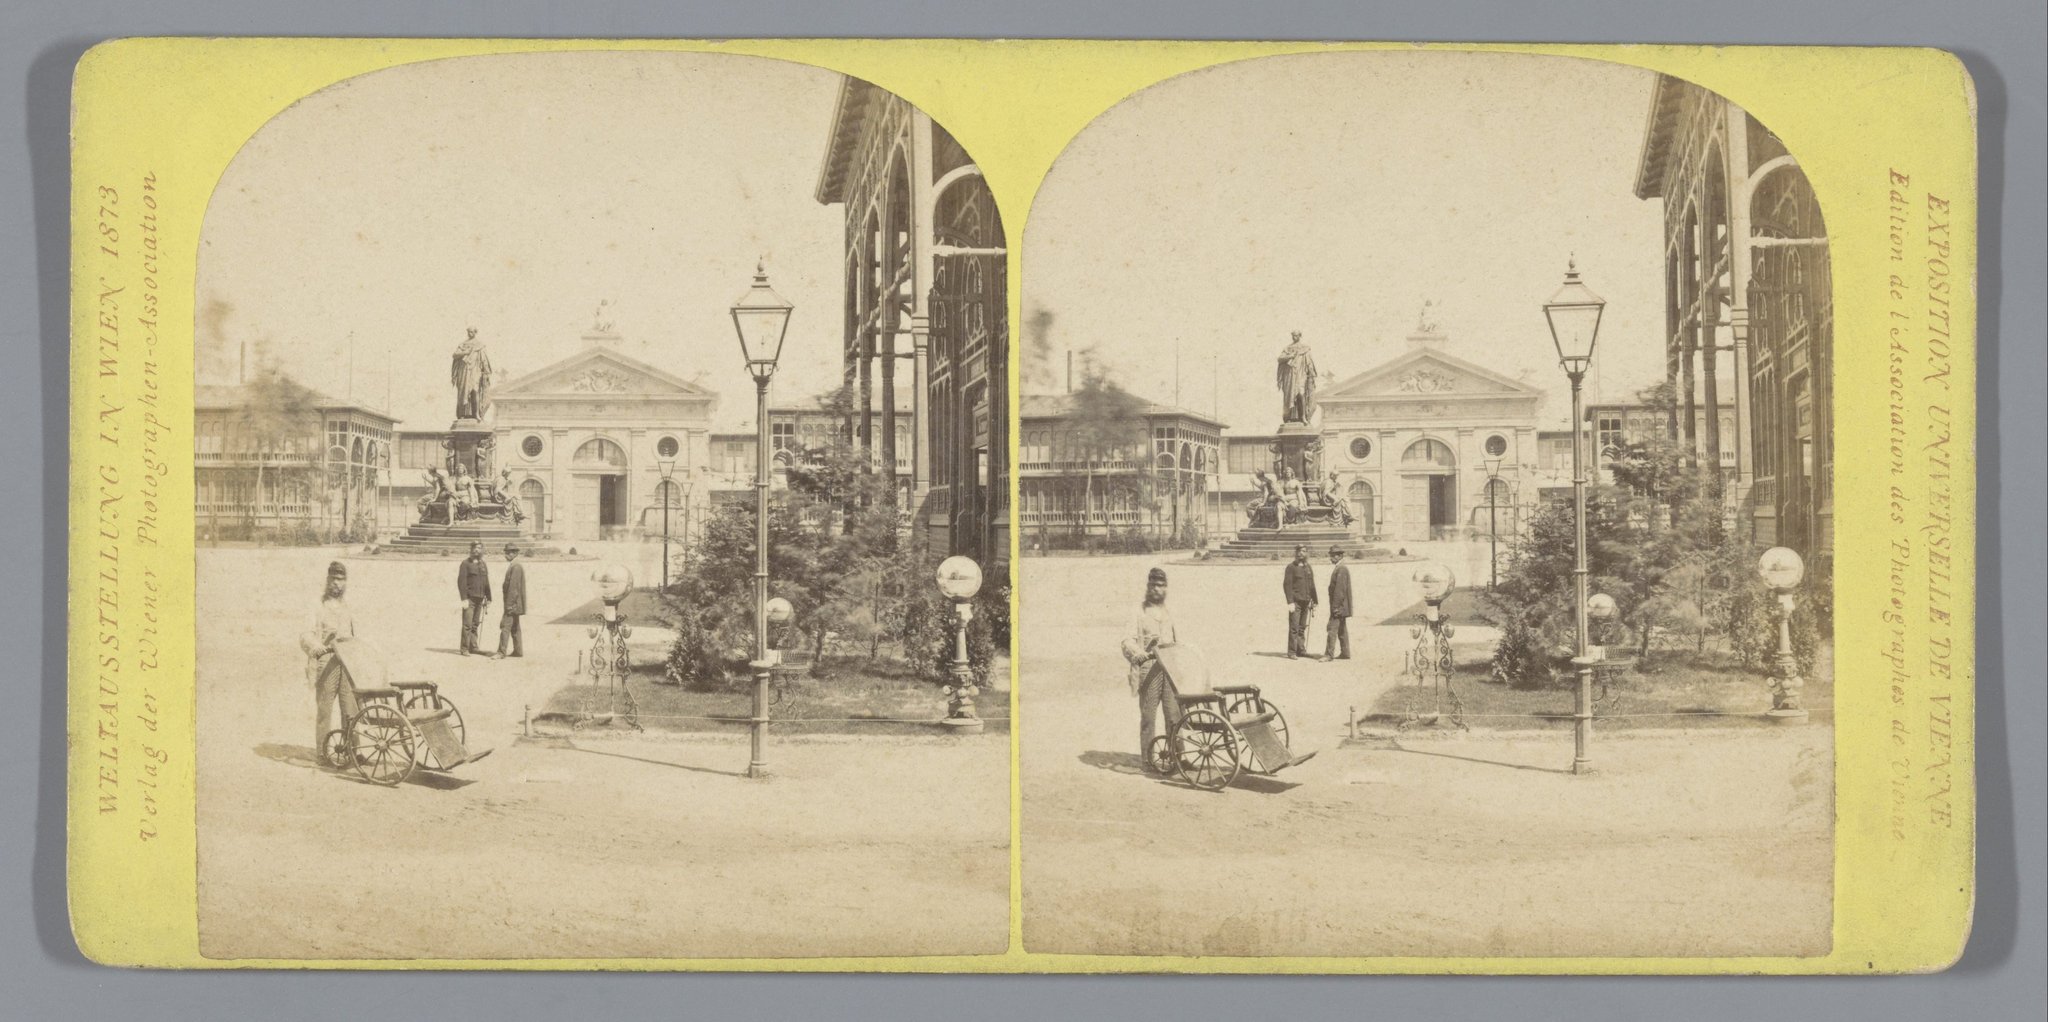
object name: stereograph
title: Weltausstellung in Wien 1873 / Exposition universelle de Vienne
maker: Anonymous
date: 1873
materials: cardboard, paper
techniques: albumen print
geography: vienna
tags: world fair, world exhibition, vienna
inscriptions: number: ‘125.’